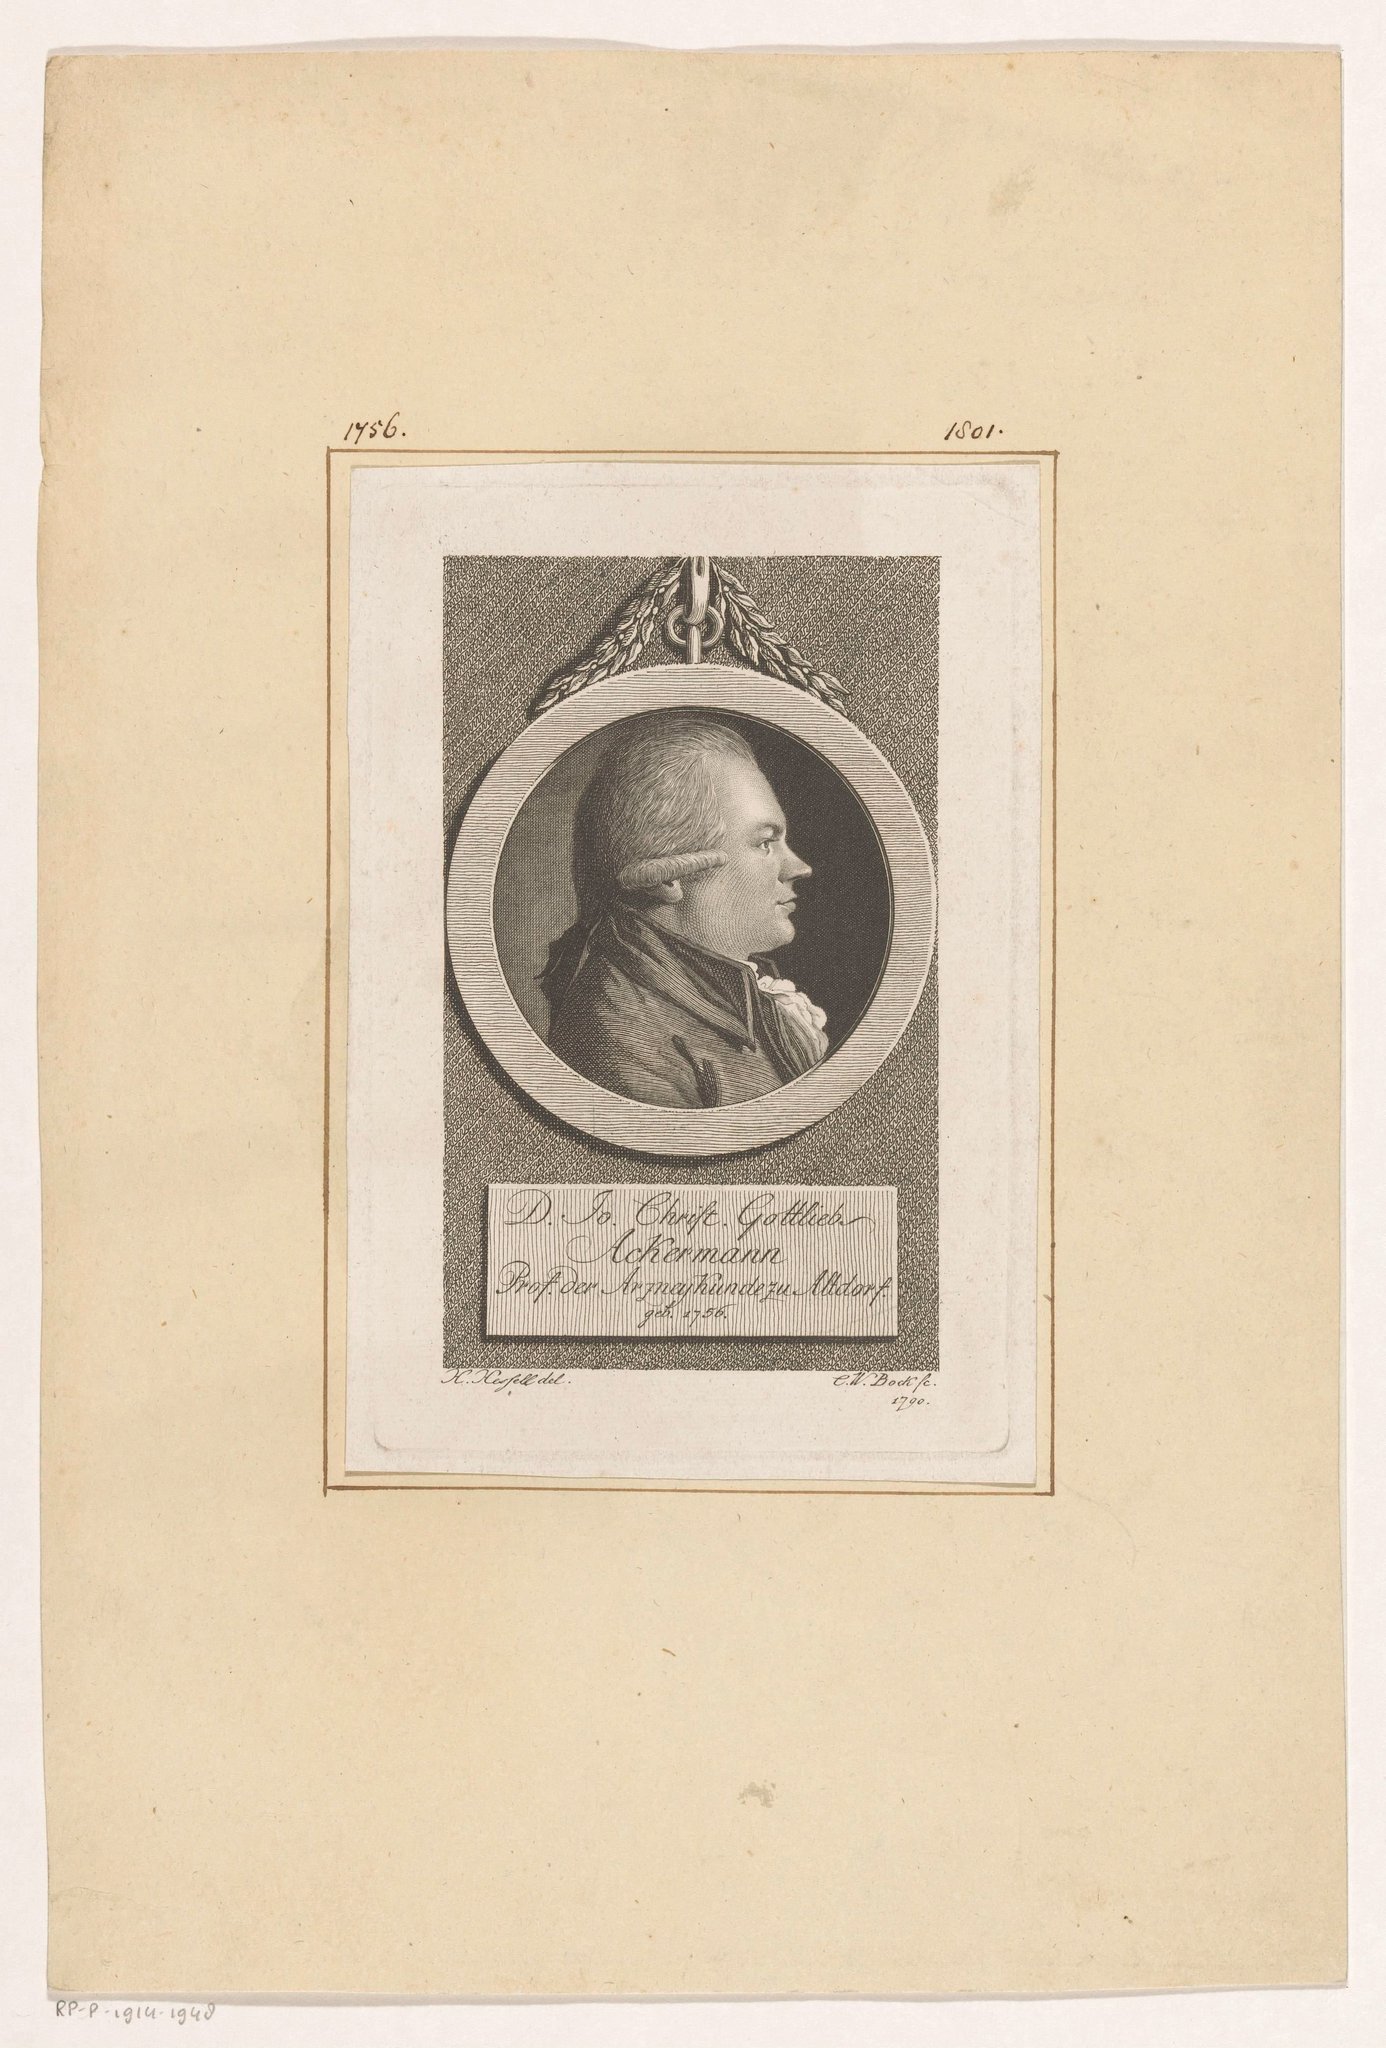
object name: print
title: Portret van Johann Christian Gottlieb Ackermann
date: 1790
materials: paper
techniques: engraving, etching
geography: nuremberg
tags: historical persons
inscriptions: date